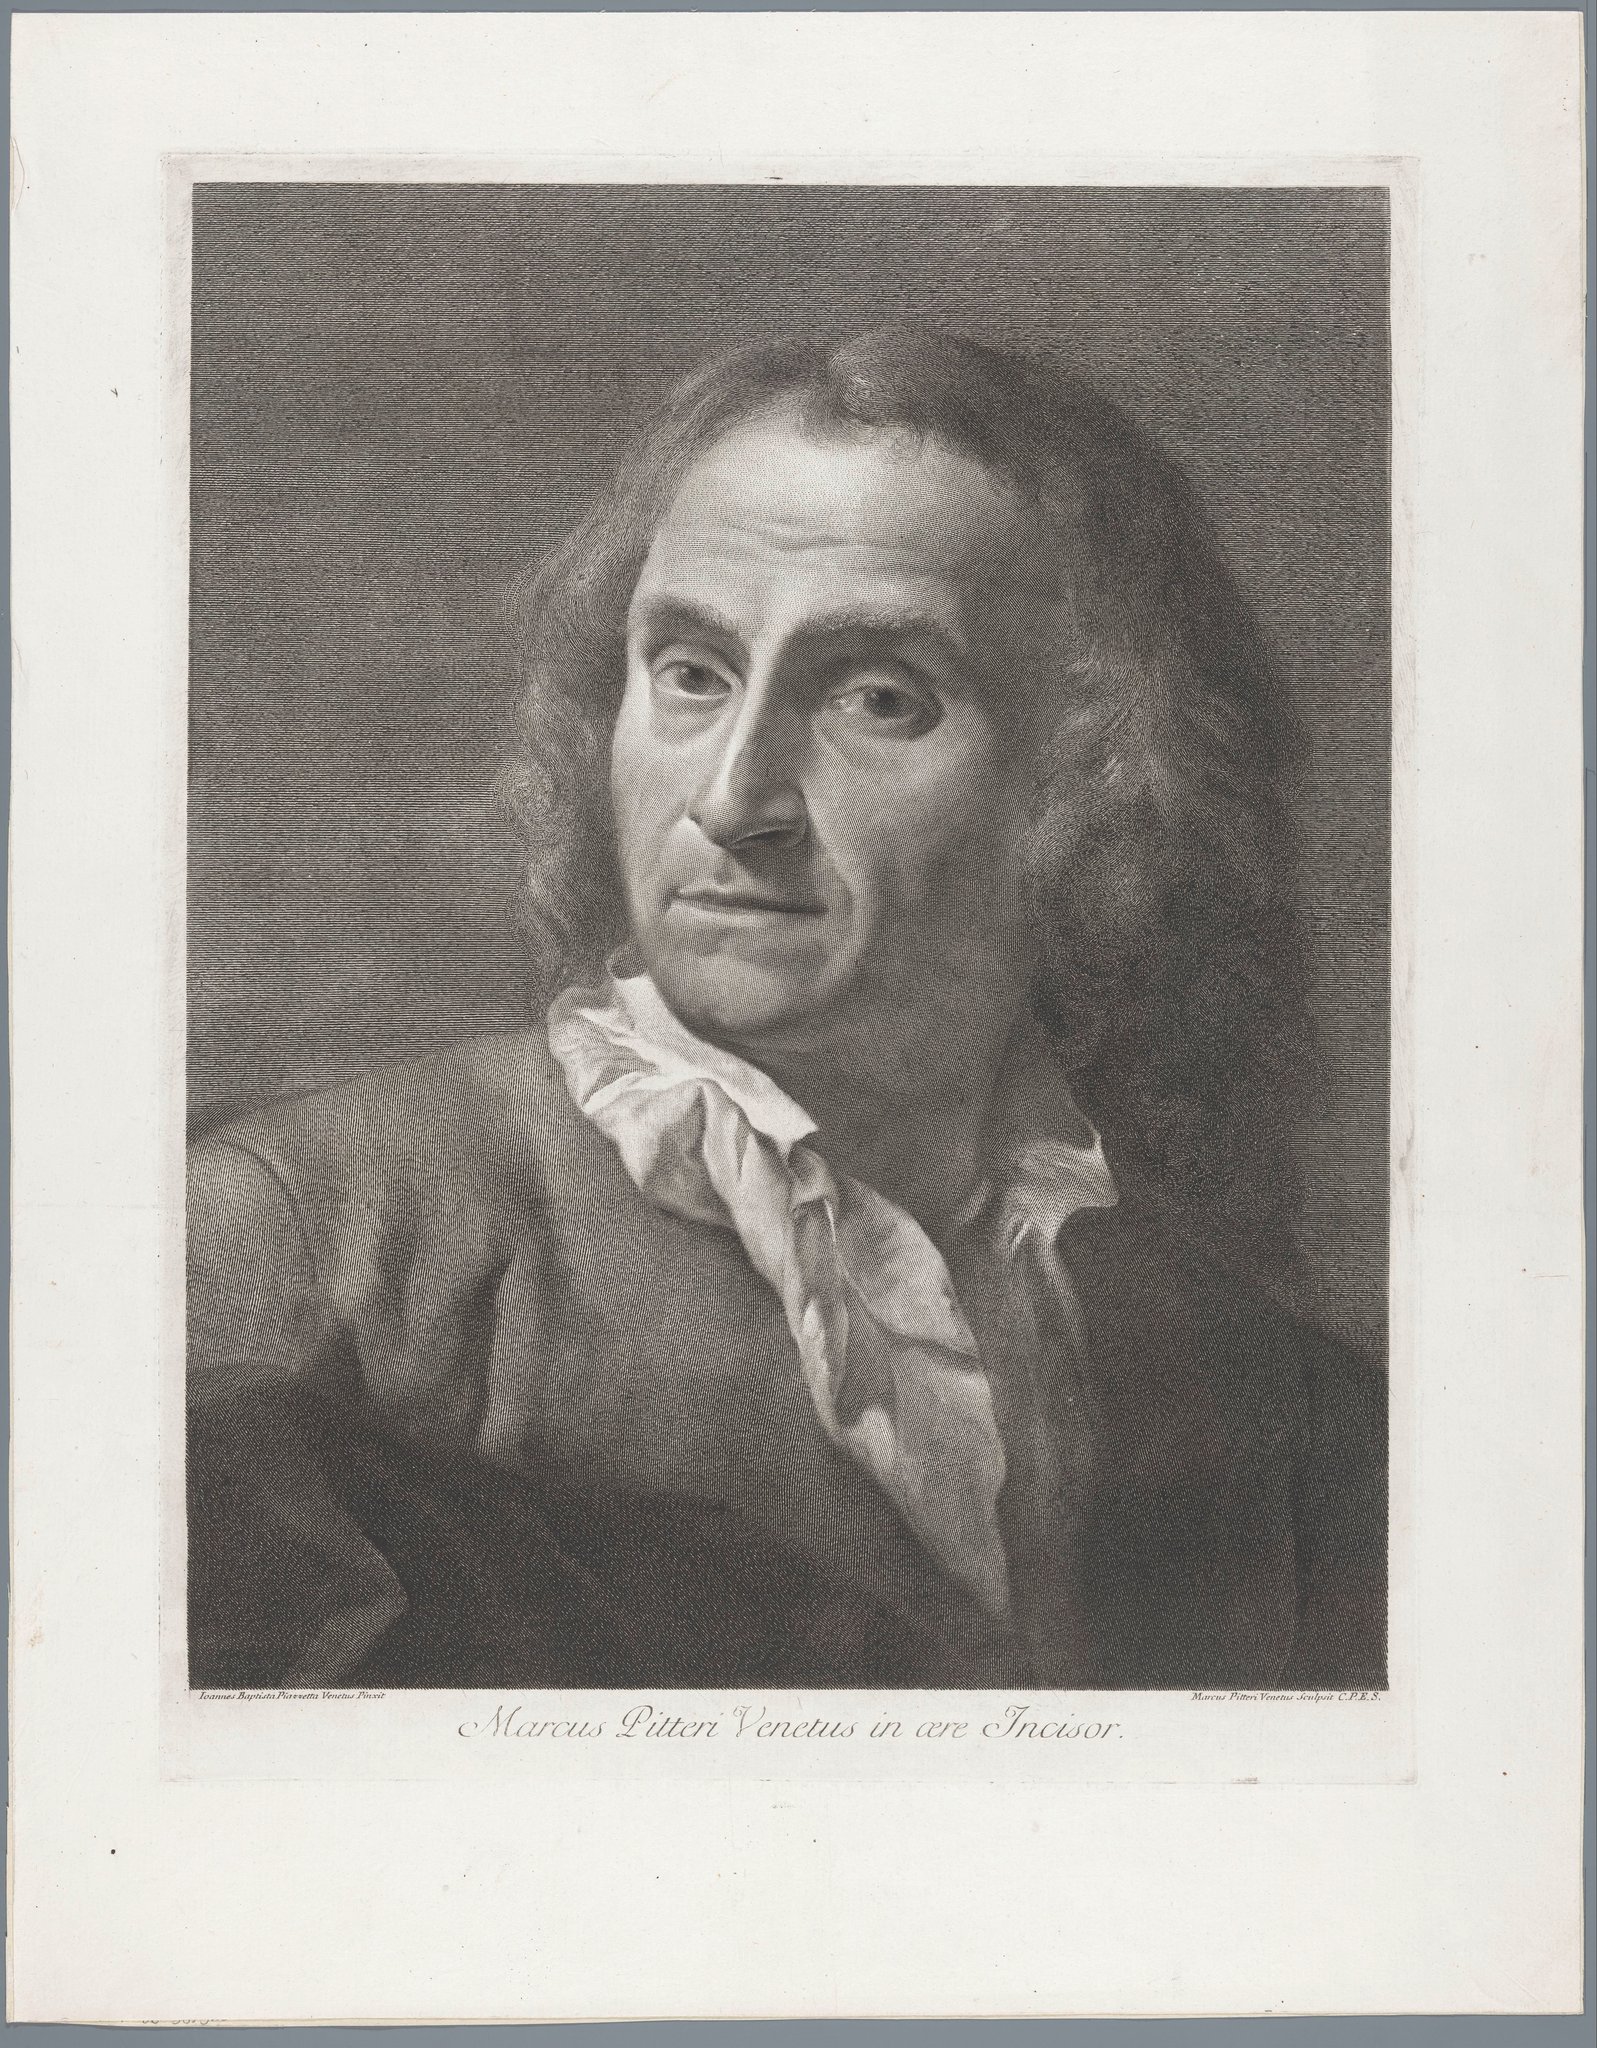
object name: print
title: Portret van prentmaker Giovanni Marco Pitteri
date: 1712-1786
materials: paper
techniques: engraving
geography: venice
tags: venice, print maker, giovanni marco pitteri, historical persons, portrait, self-portrait of artist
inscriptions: collector's mark: Lugt 240